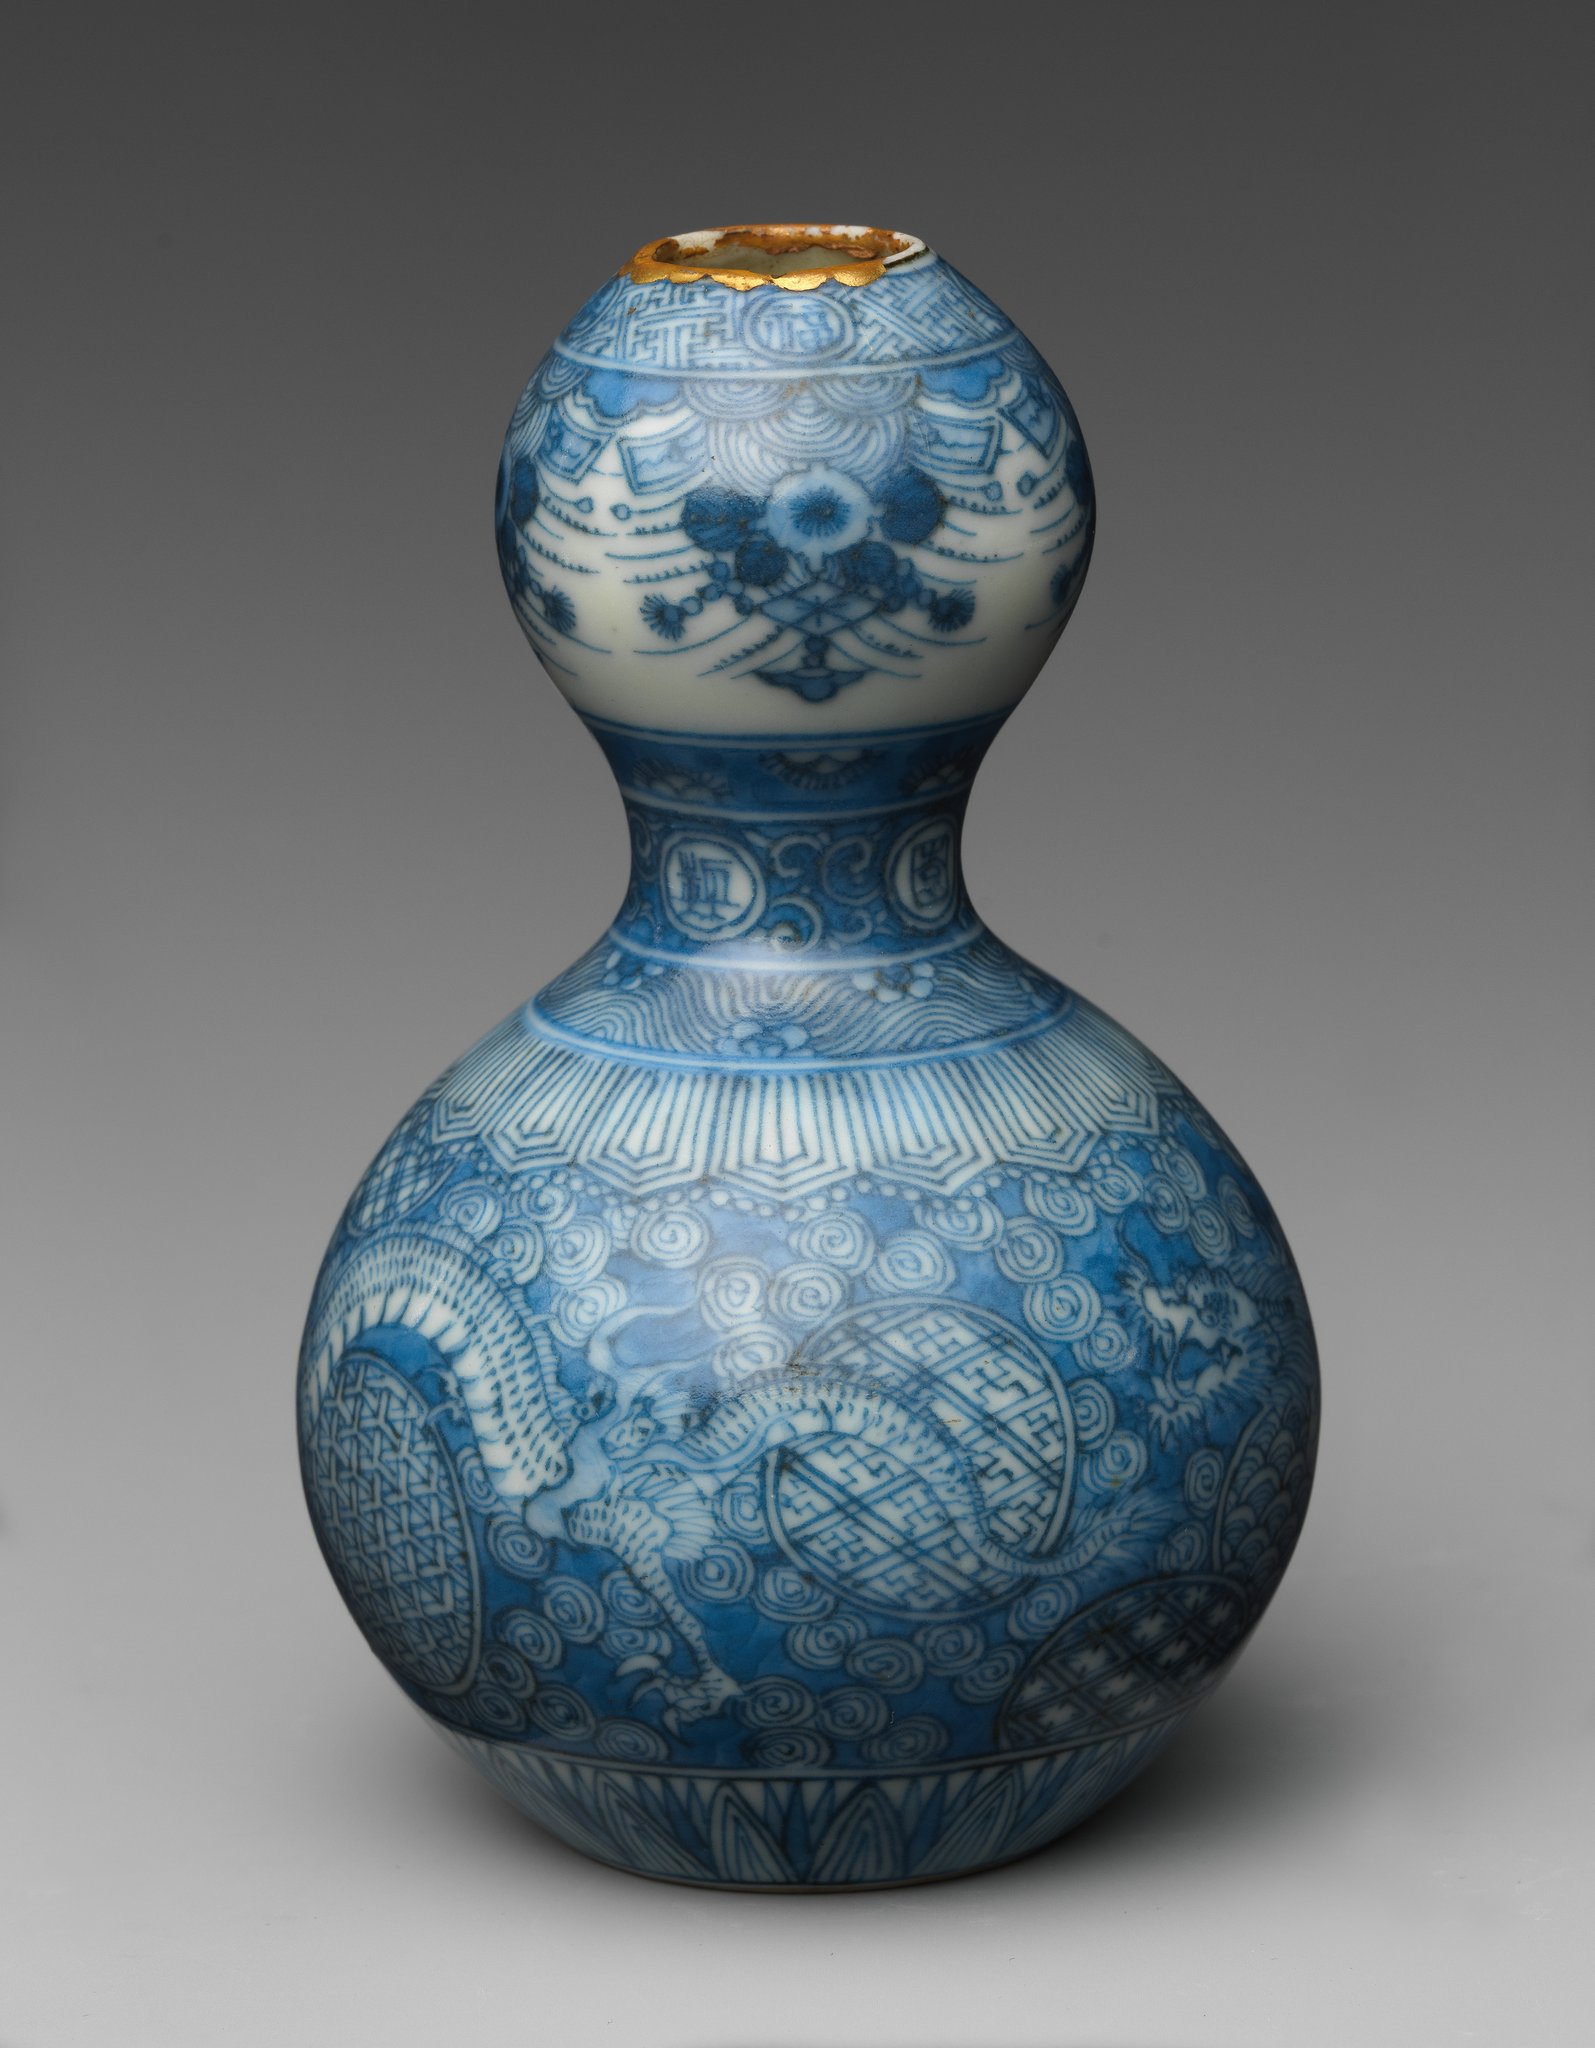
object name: bottle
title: Small Gourd-Shaped Bottle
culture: japanese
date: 1800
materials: porcelain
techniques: underglaze